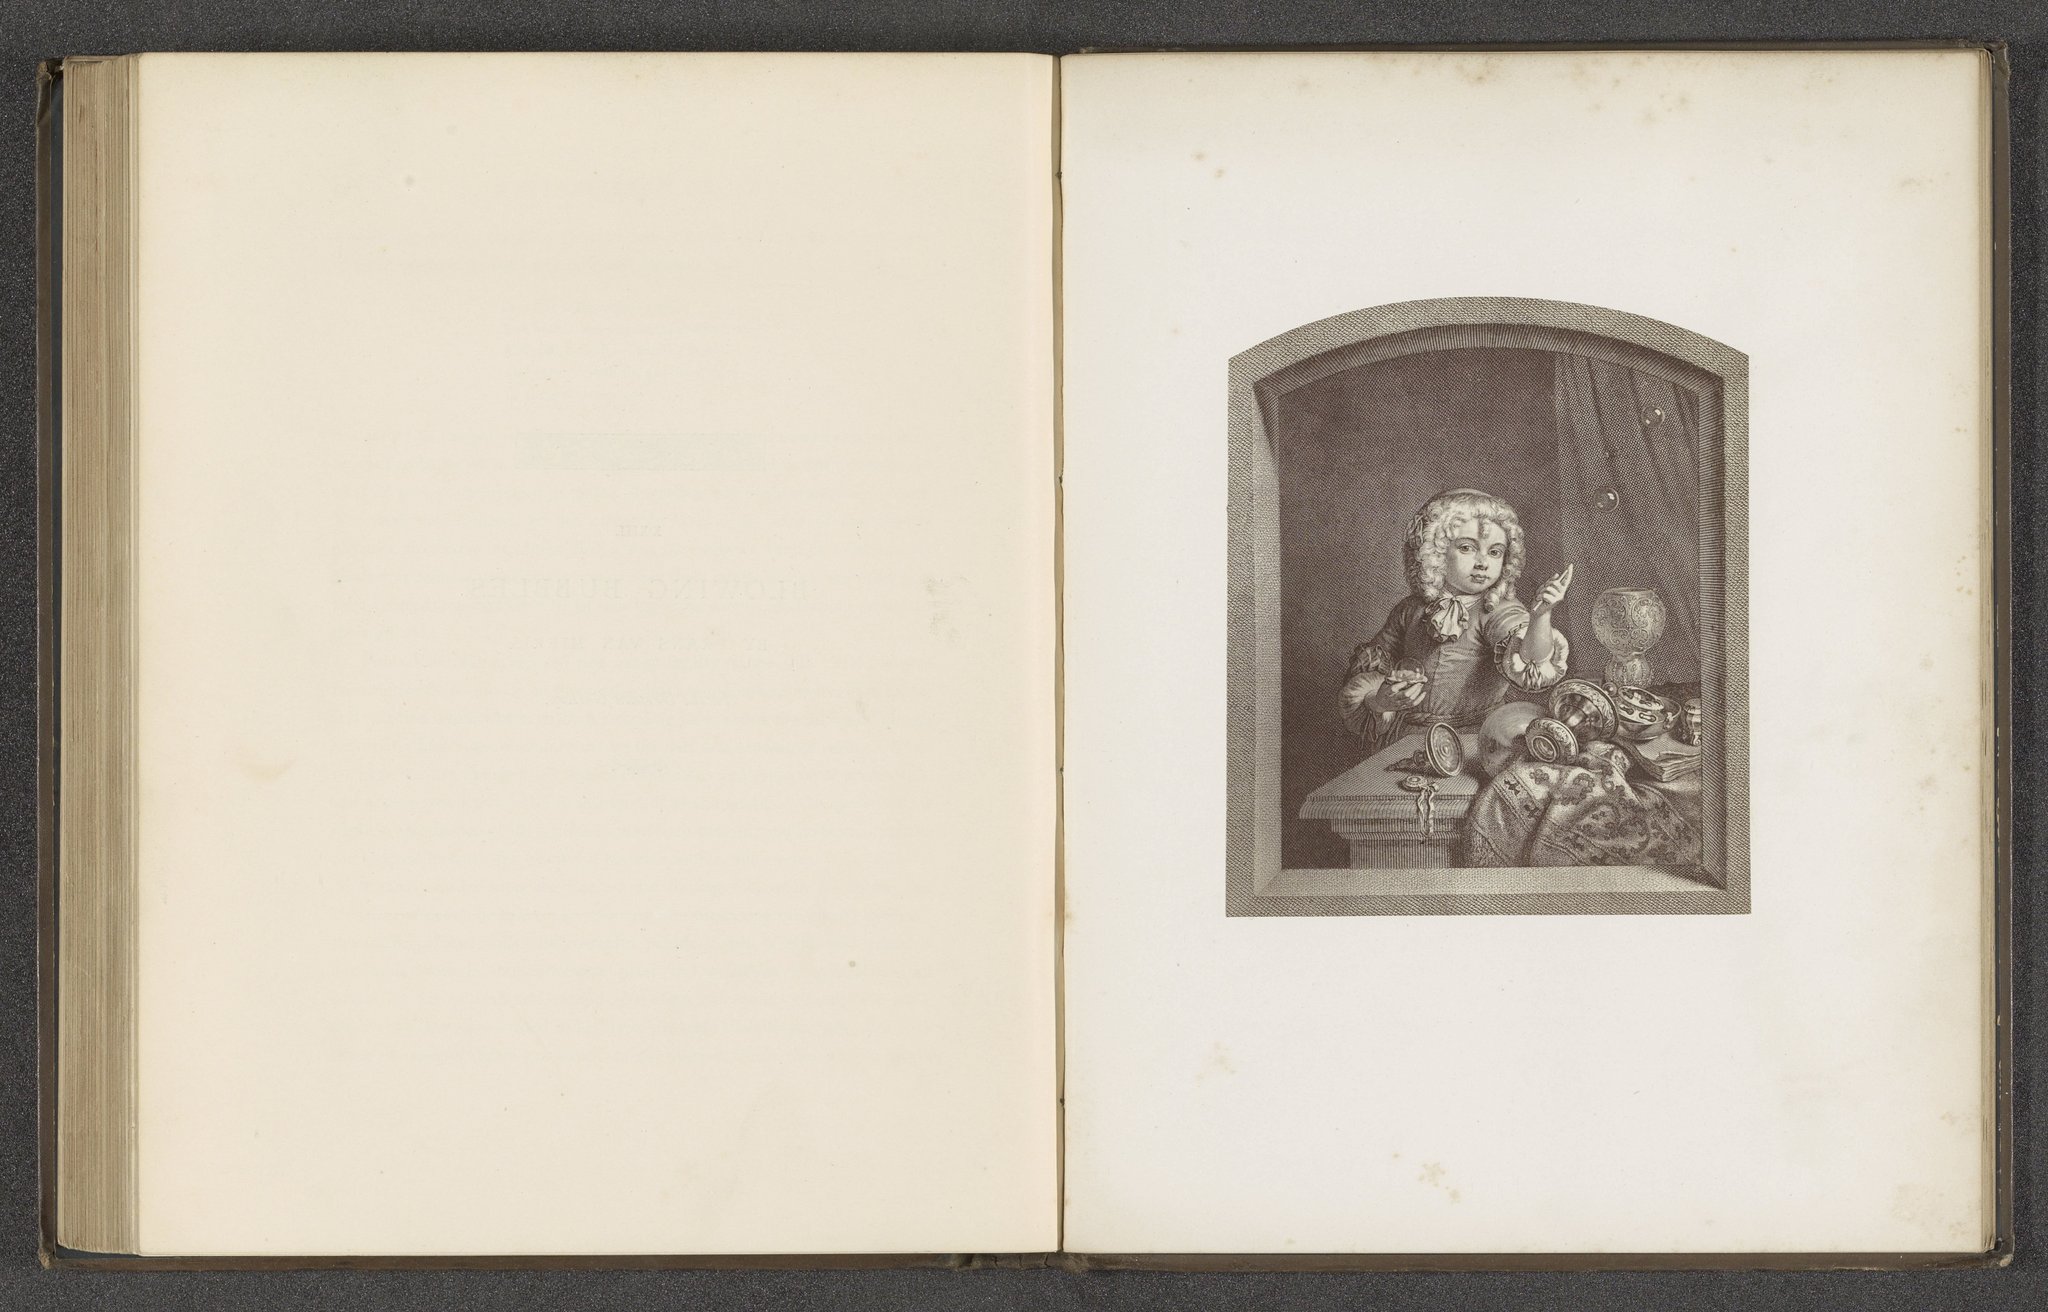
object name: page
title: Fotoreproductie van een prent naar een schilderij, voorstellende een jongen blaast bellen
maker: Anonymous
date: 1859-1869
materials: paper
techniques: woodburytype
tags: bubble-blowing (children's games and plays), (children or putti) blowing bubbles, 'homo bulla' ~ scene symbolizing 'vanitas'